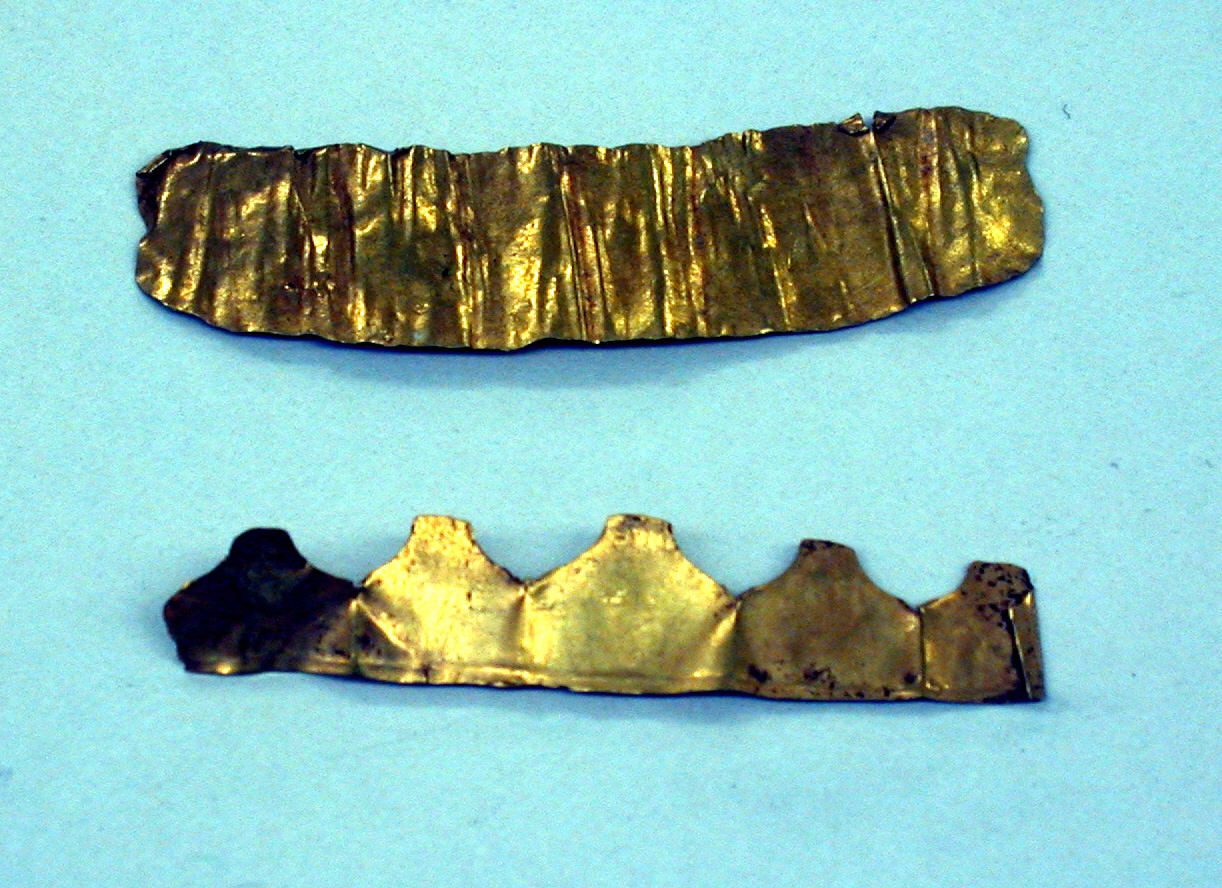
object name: labret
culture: mindanao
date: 1301-1500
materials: gold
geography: philippines